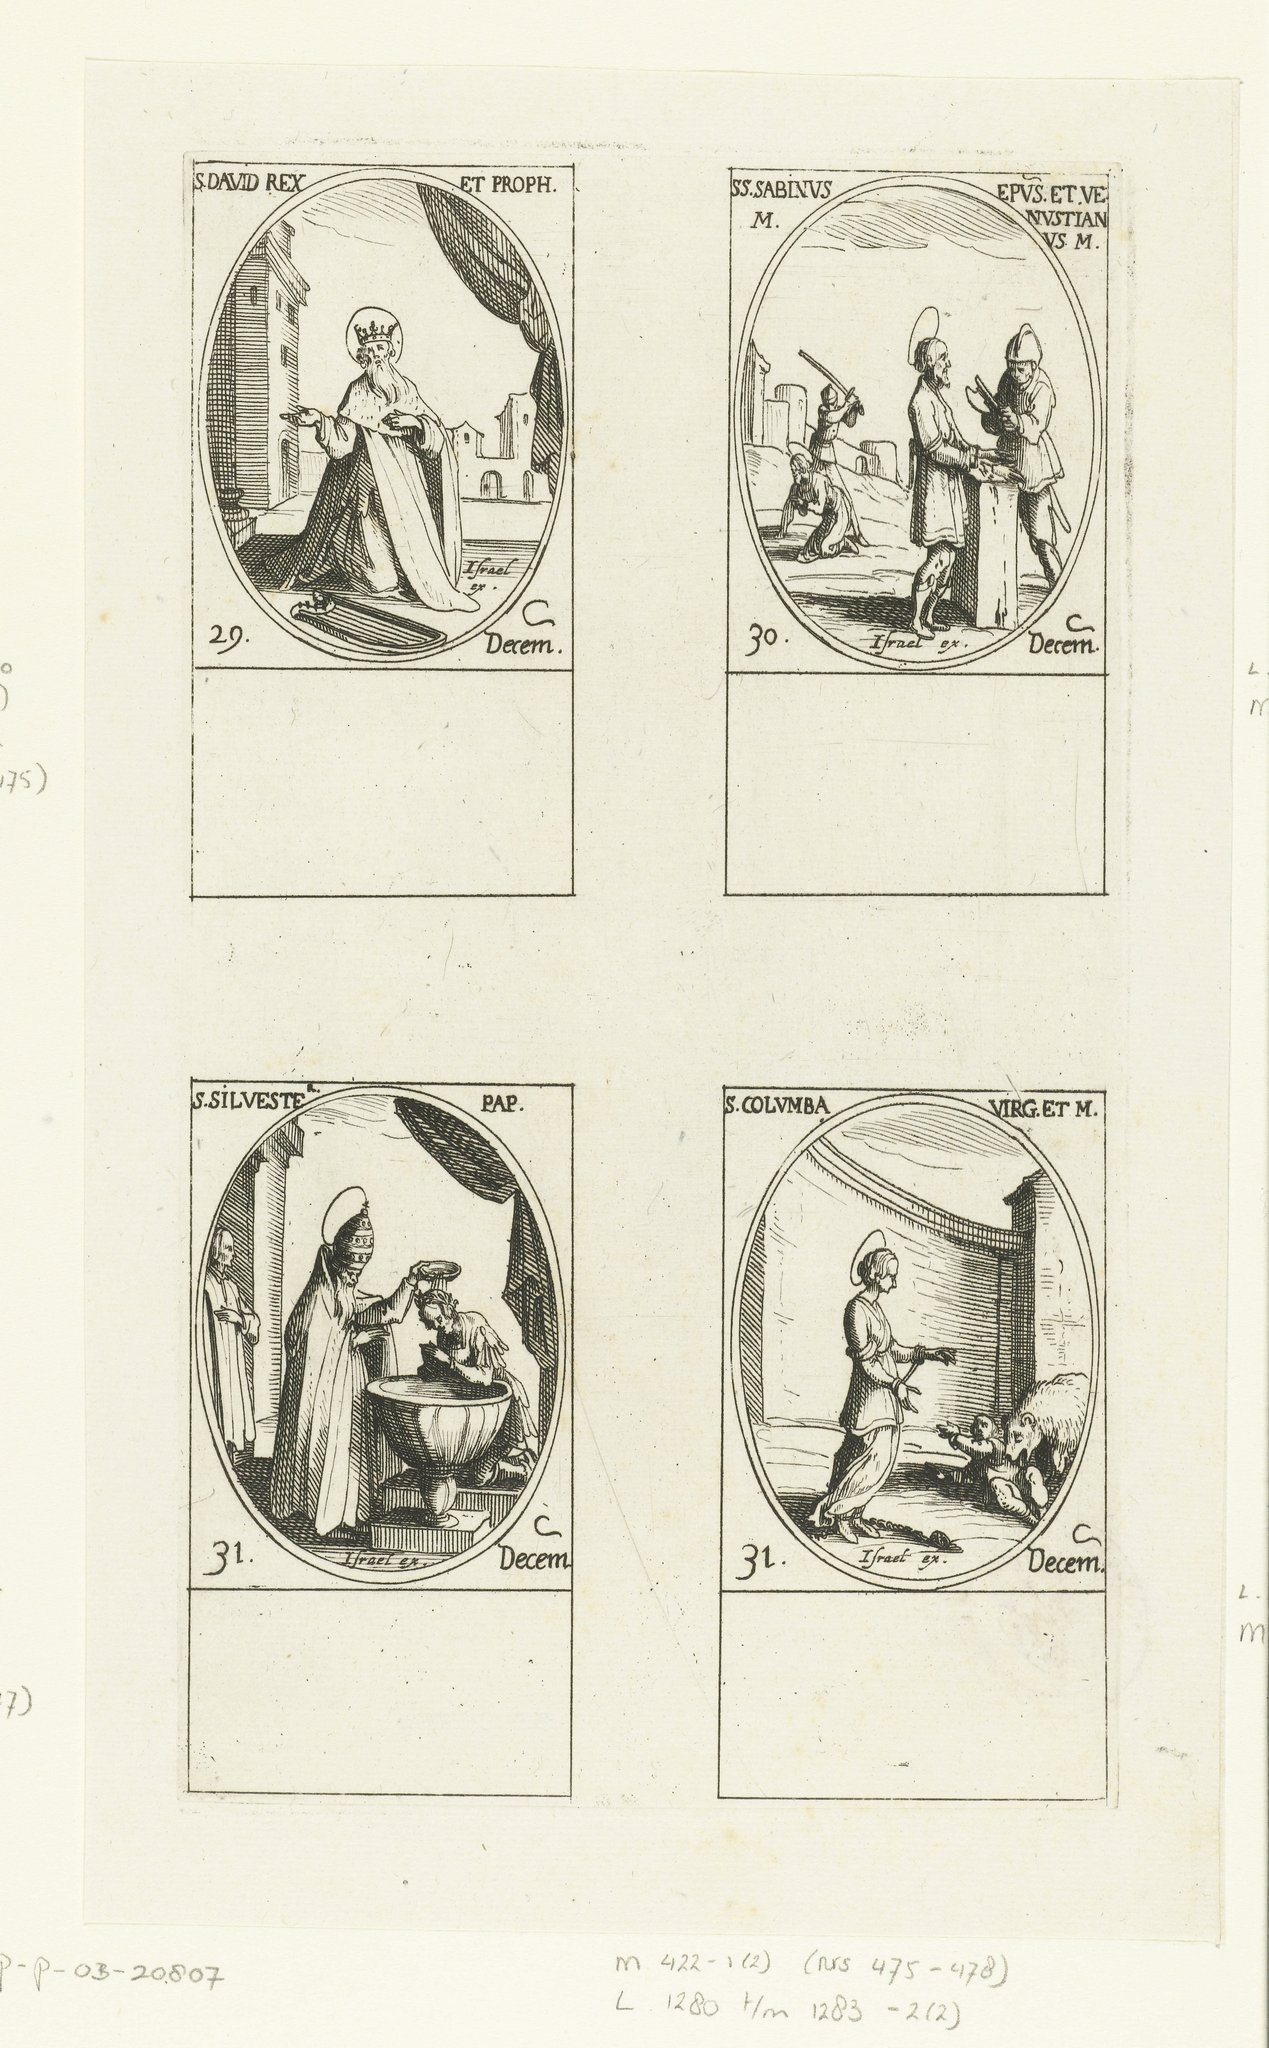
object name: print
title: Alle heiligen en de Christelijke feestdagen van het jaar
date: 1632-1636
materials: paper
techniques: etching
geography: paris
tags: david (not in biblical context); possible attributes: crown, harp, st. sylvester baptizes emperor constantine the great, female saints (with name), male saints (with name)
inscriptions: collector's mark: Lugt 240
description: Blad met vier ovale voorstellingen, elk met opschrift en datum in het Latijn: linksboven koning David met zijn harp, rechtsboven de Heilige Venustianus die de Heilige Sabinus de handen afhakt, linksonder de Heilige Silvester I als paus die keizer Constantijn doopt, rechtsonder de Heilige Columba van Sens geketend bij een man (kind?) die aangevallen wordt door een beer. Deze prent is onderdeel van een serie prenten met voorstellingen van de heiligen en de christelijke feestdagen van het jaar. Er zijn steeds vier scènes van één plaat op één blad gedrukt. Inclusief bijbehorend titelblad en frontispice gaat het in totaal om 124 platen (490 voorstellingen). De drie platen met de laatste 12 scènes (de veranderlijke christelijke feestdagen) zijn in de derde staat versneden tot 12 kleine plaatjes, en met een apart titelblad uitgegeven.